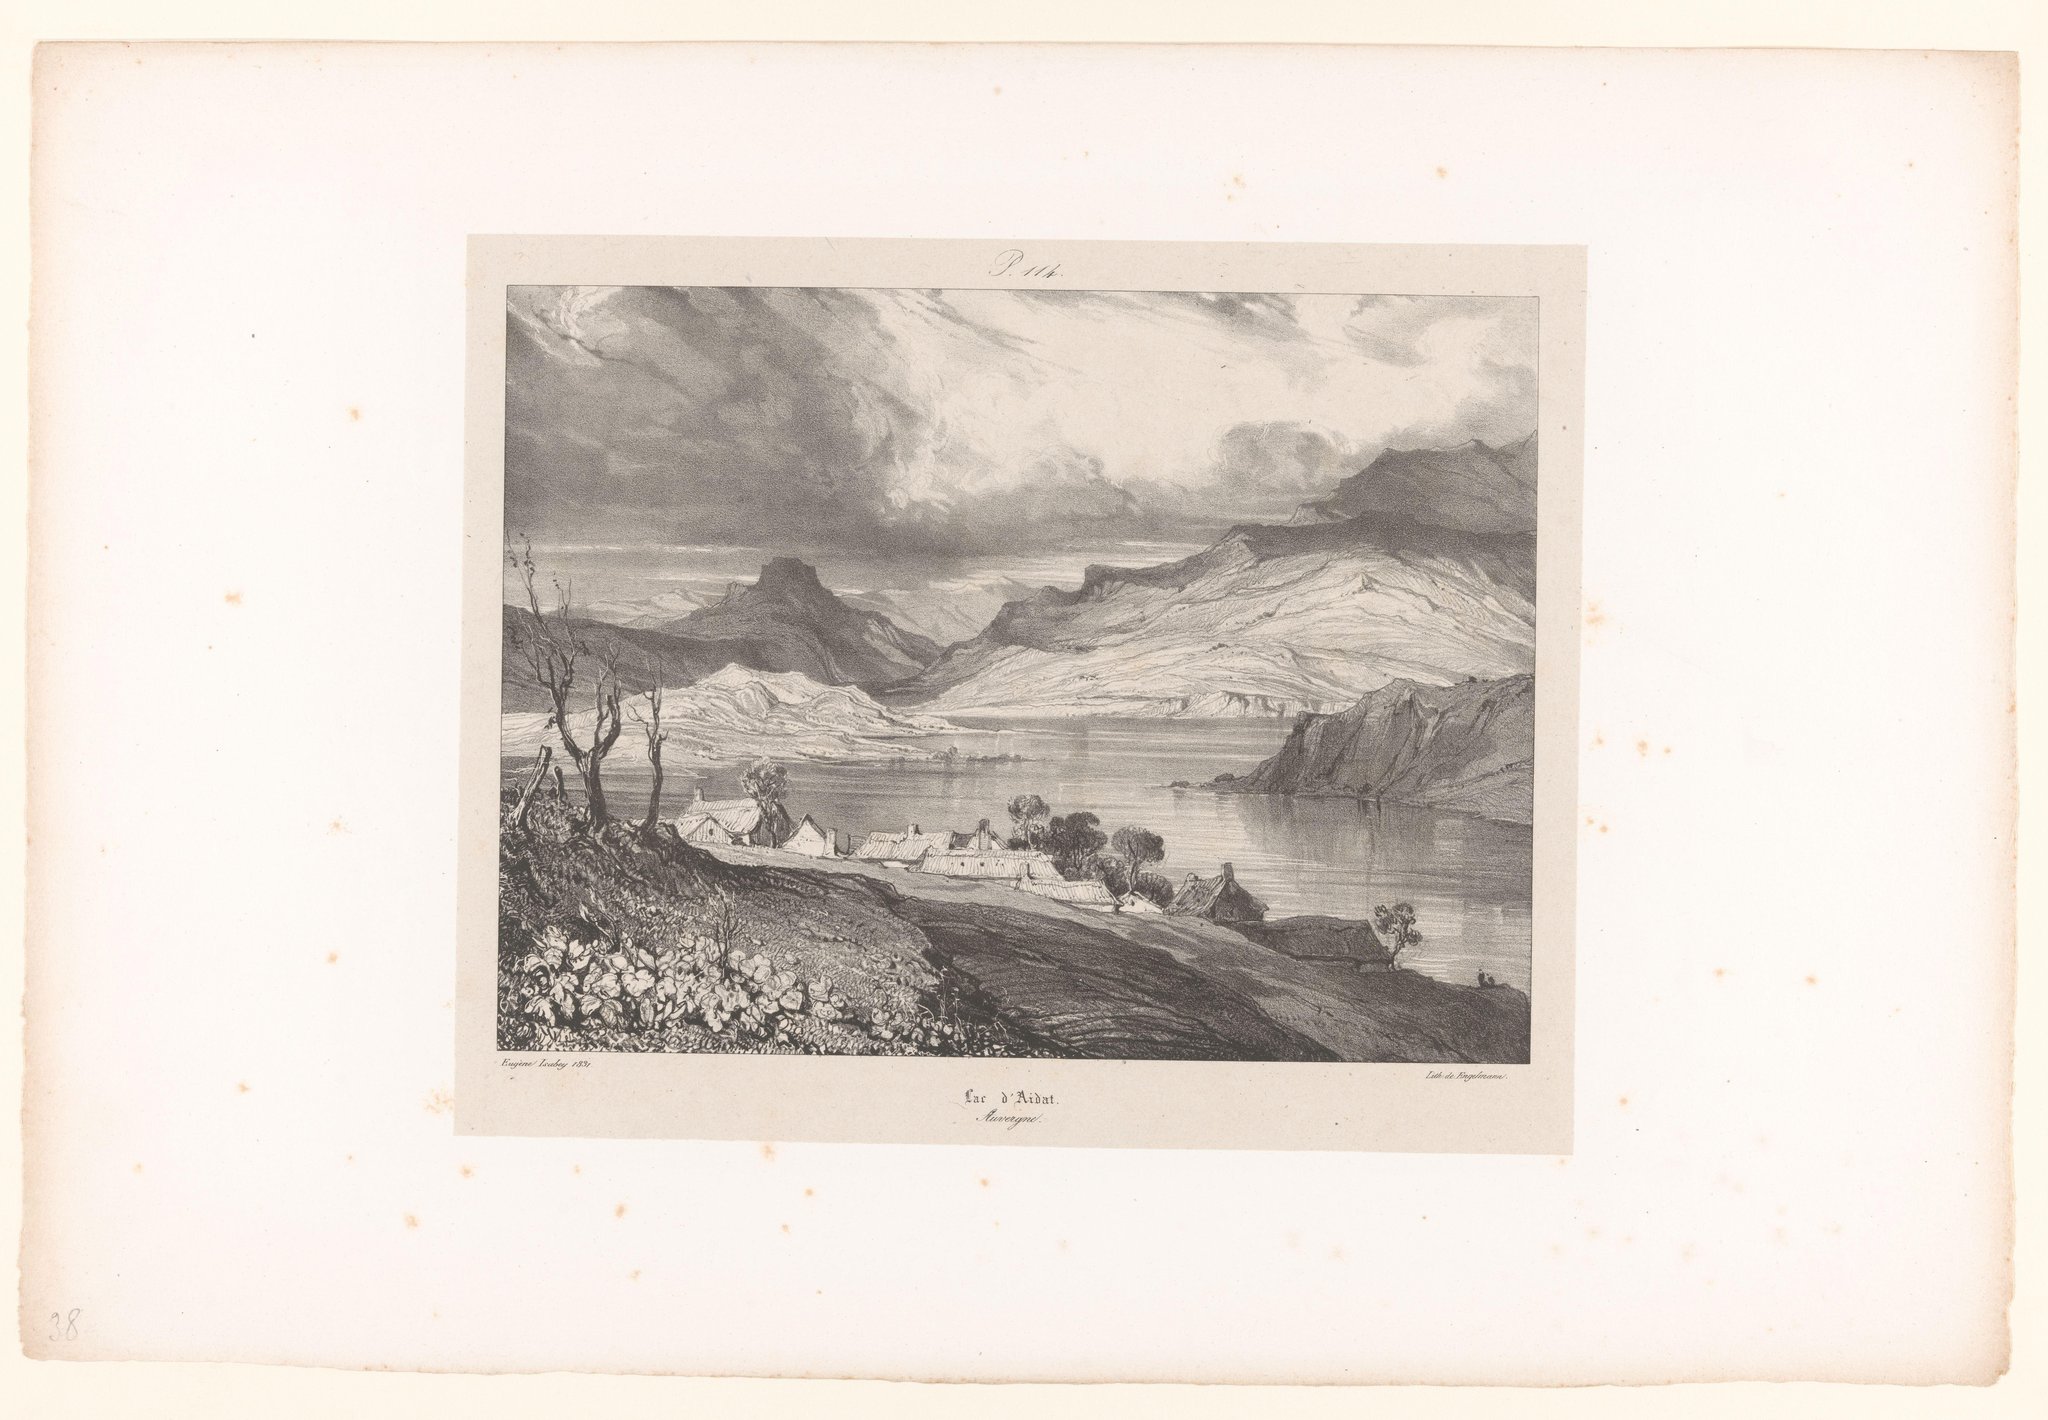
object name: print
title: Lac d'Aidat, Auvergne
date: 1831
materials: paper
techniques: lithograph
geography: paris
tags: mountains (+ landscape with figures, staffage), lake (+ landscape with figures, staffage)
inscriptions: collector's mark: Lugt 2228a, collector's mark: Lugt 2760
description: Prent gebruikt voor: Nodier, Ch. en Taylor, I. Voyages pittoresques et romantiques dans l'ancienne France. Auvergne. Parijs: Casimir Gide, 1829-1833. dl. 1, p. 114.